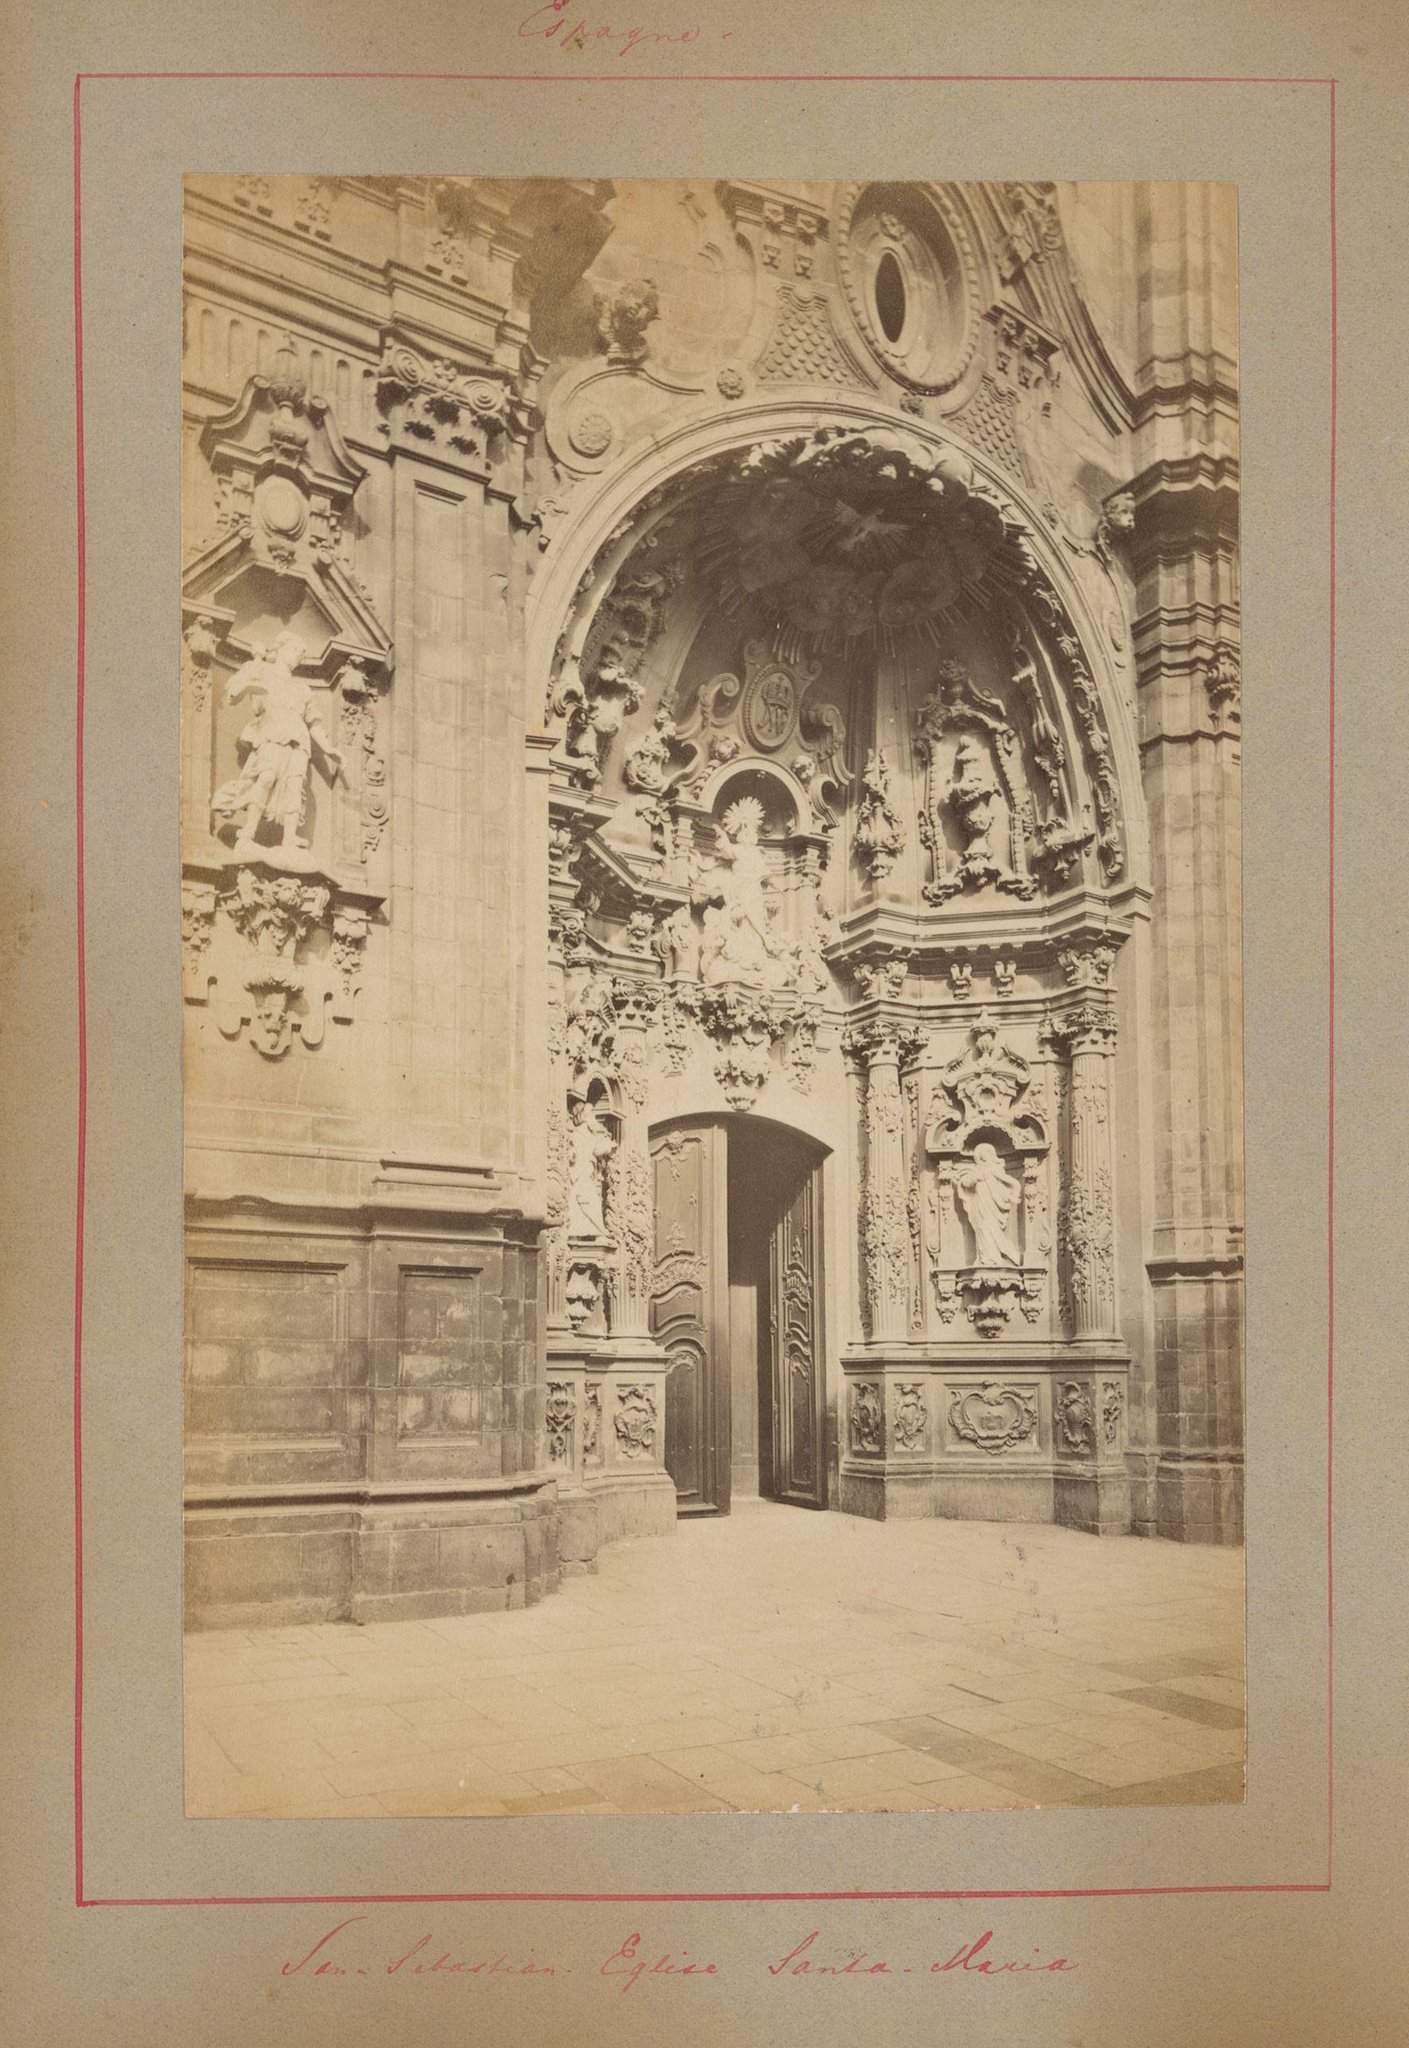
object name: album leaf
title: Portaal van de Basílica de Nuestra Señora del Coro te San Sebastian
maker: Anonymous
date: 1880-1910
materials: photographic support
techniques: albumen print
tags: parts of church exterior and annexes: portal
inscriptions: annotation: ‘Espagne/ San Sebastian Eglise Santa-Maria’